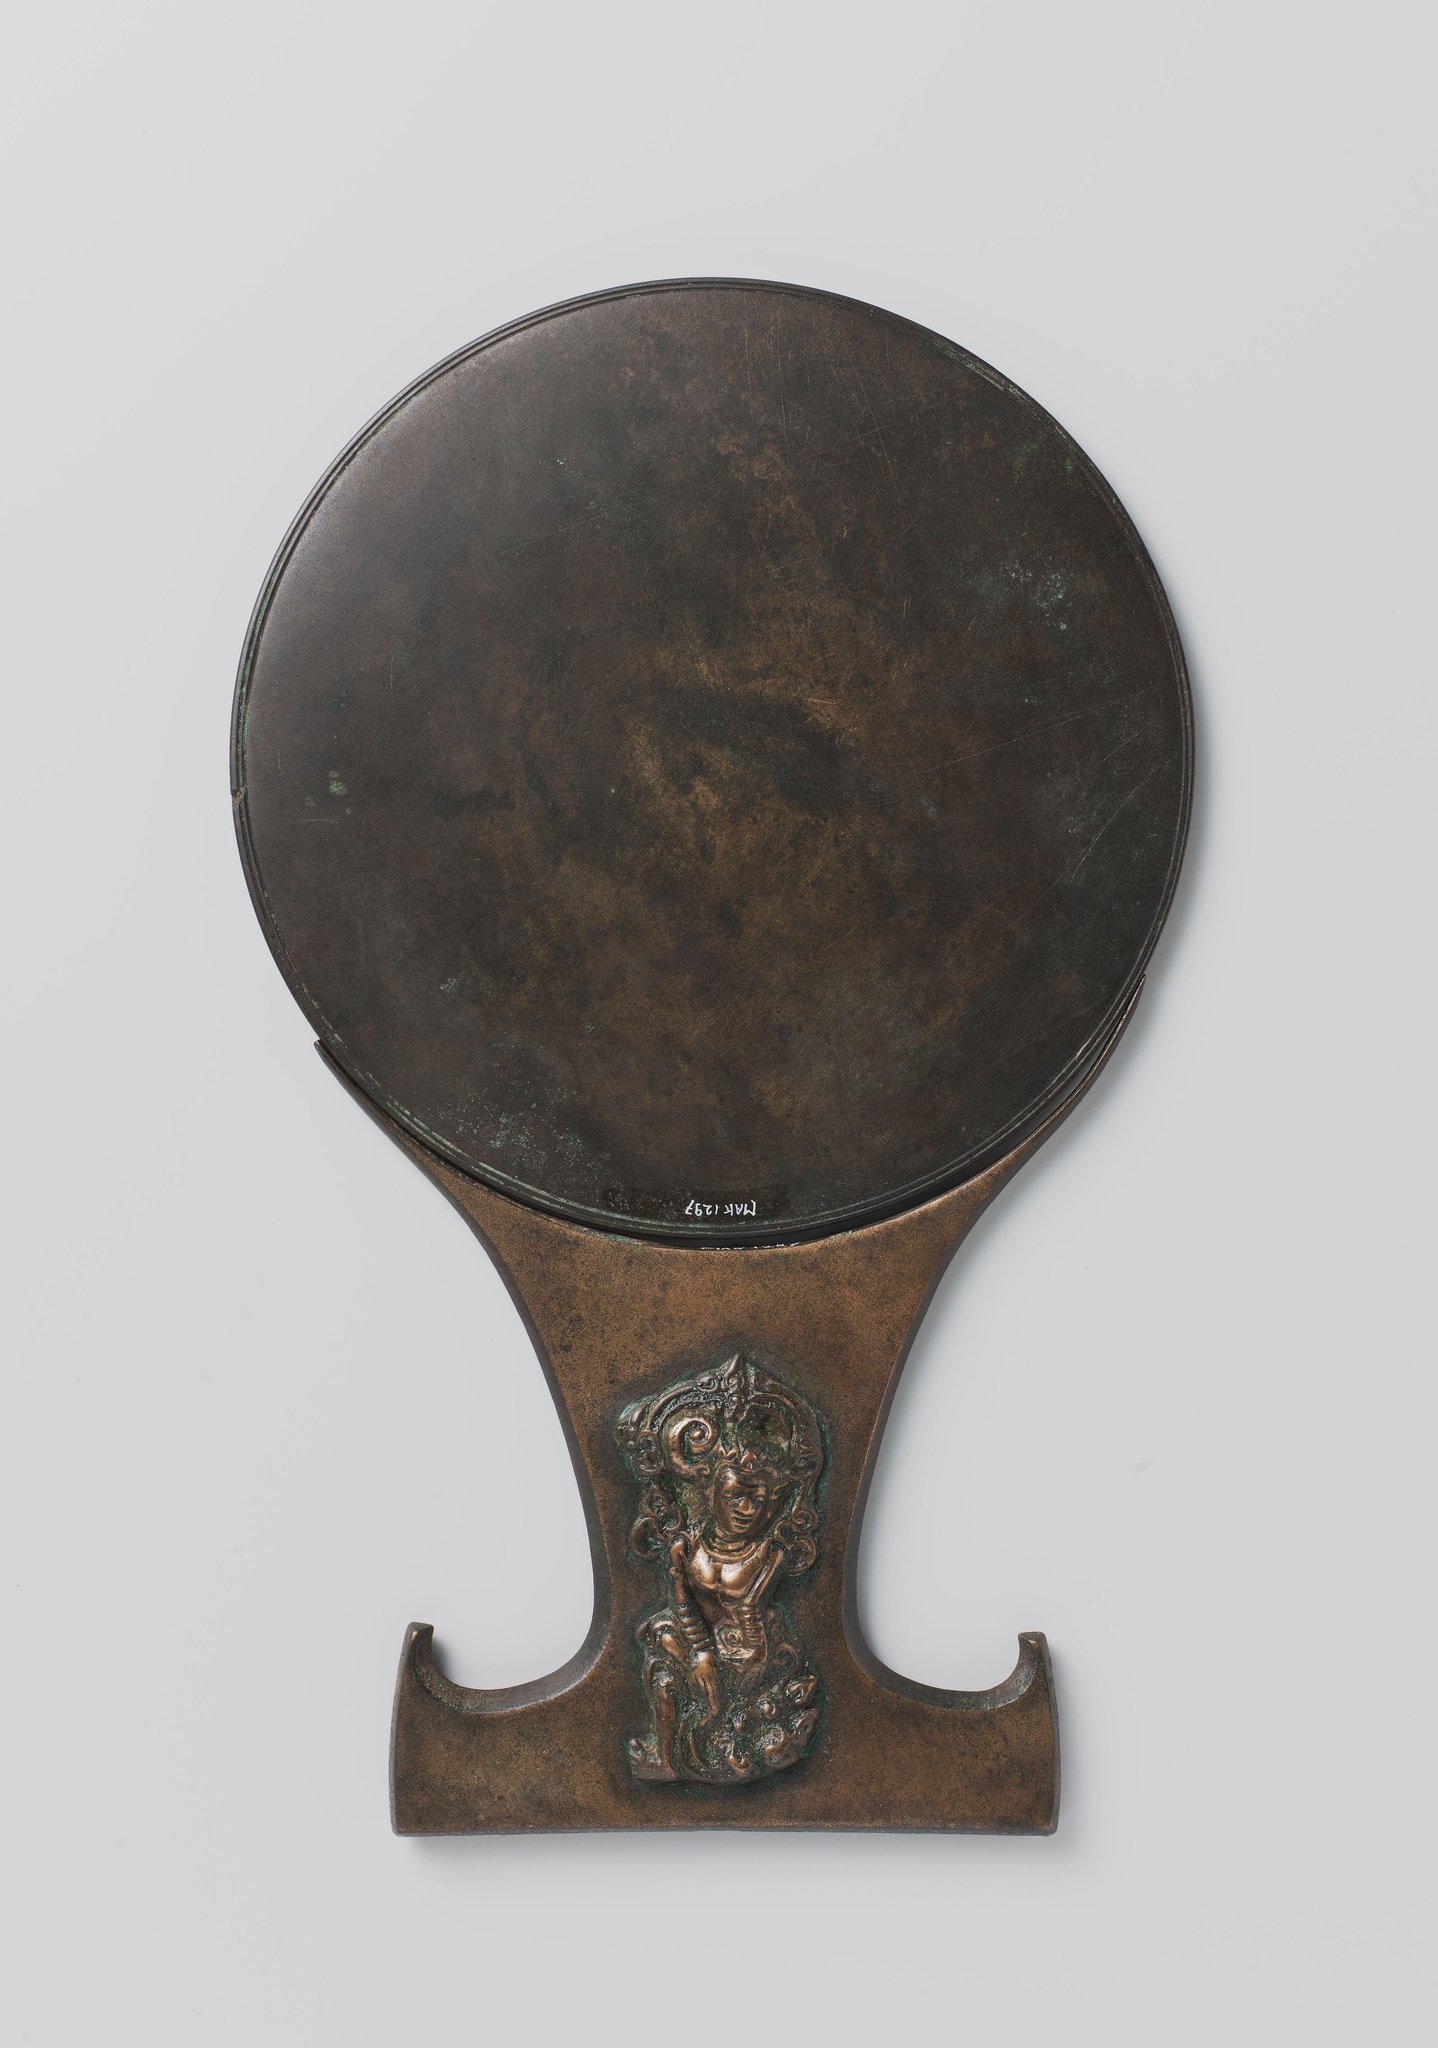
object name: mirror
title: Mirrors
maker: Anonymous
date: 1300-1400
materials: bronze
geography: east java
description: In making these mirrors the disk and the handle were cast separately. The bronze disc was polished to a high shine and the handle adorned with decorative details, such as openwork motifs or gilded reliefs. Bronze mirrors could also have a ritual function, whereby the image of the divinity was reflected in the polished surface and thus establishing a connection between the spiritual and the mundane worlds.